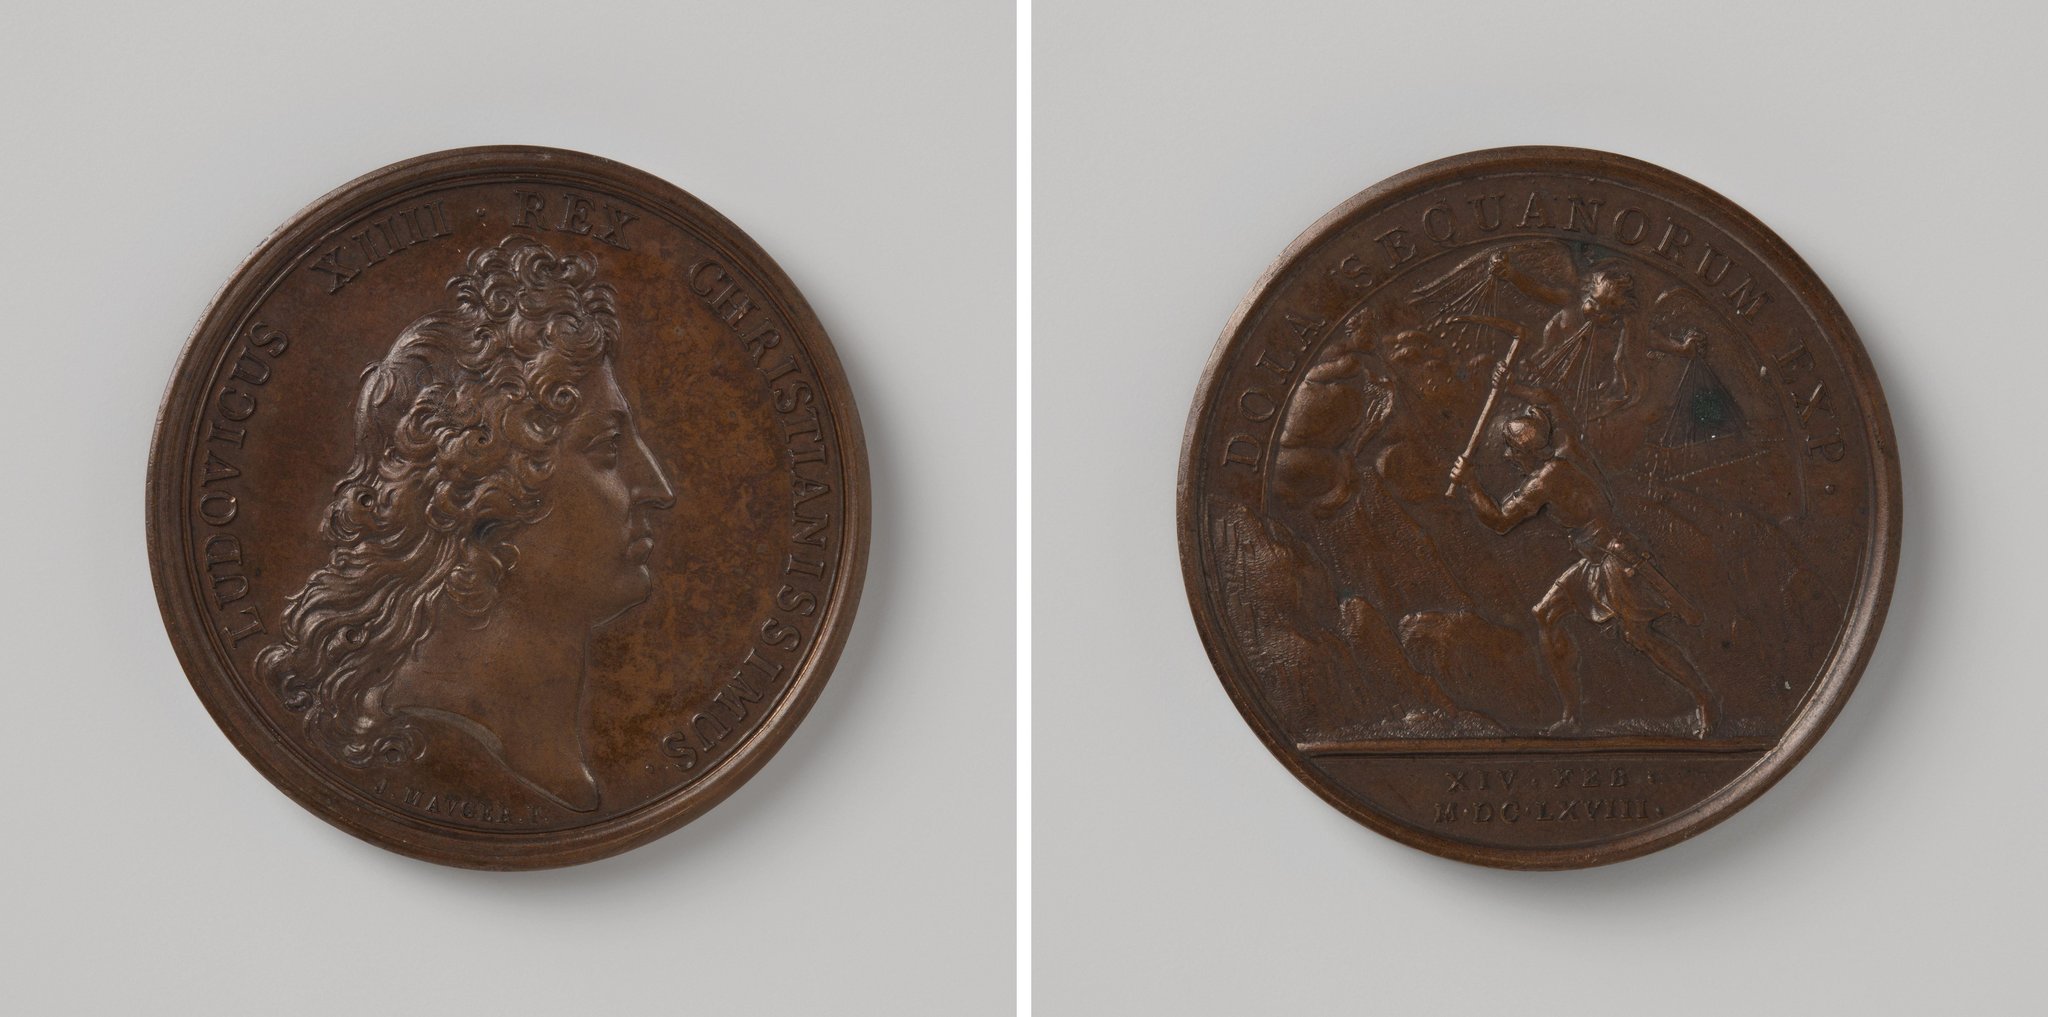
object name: history medal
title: Dole ingenomen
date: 1699-1703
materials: bronze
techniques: striking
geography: paris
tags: lodewijk xiv (koning van frankrijk)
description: Bronzen penning. Voorzijde: borststuk man (Lodewijk XIV) binnen omschrift. Keerzijde: Franse soldaat opent met houweel de loopgraven ondanks dat de Wind hem teistert met slecht weer binnen omschrift.